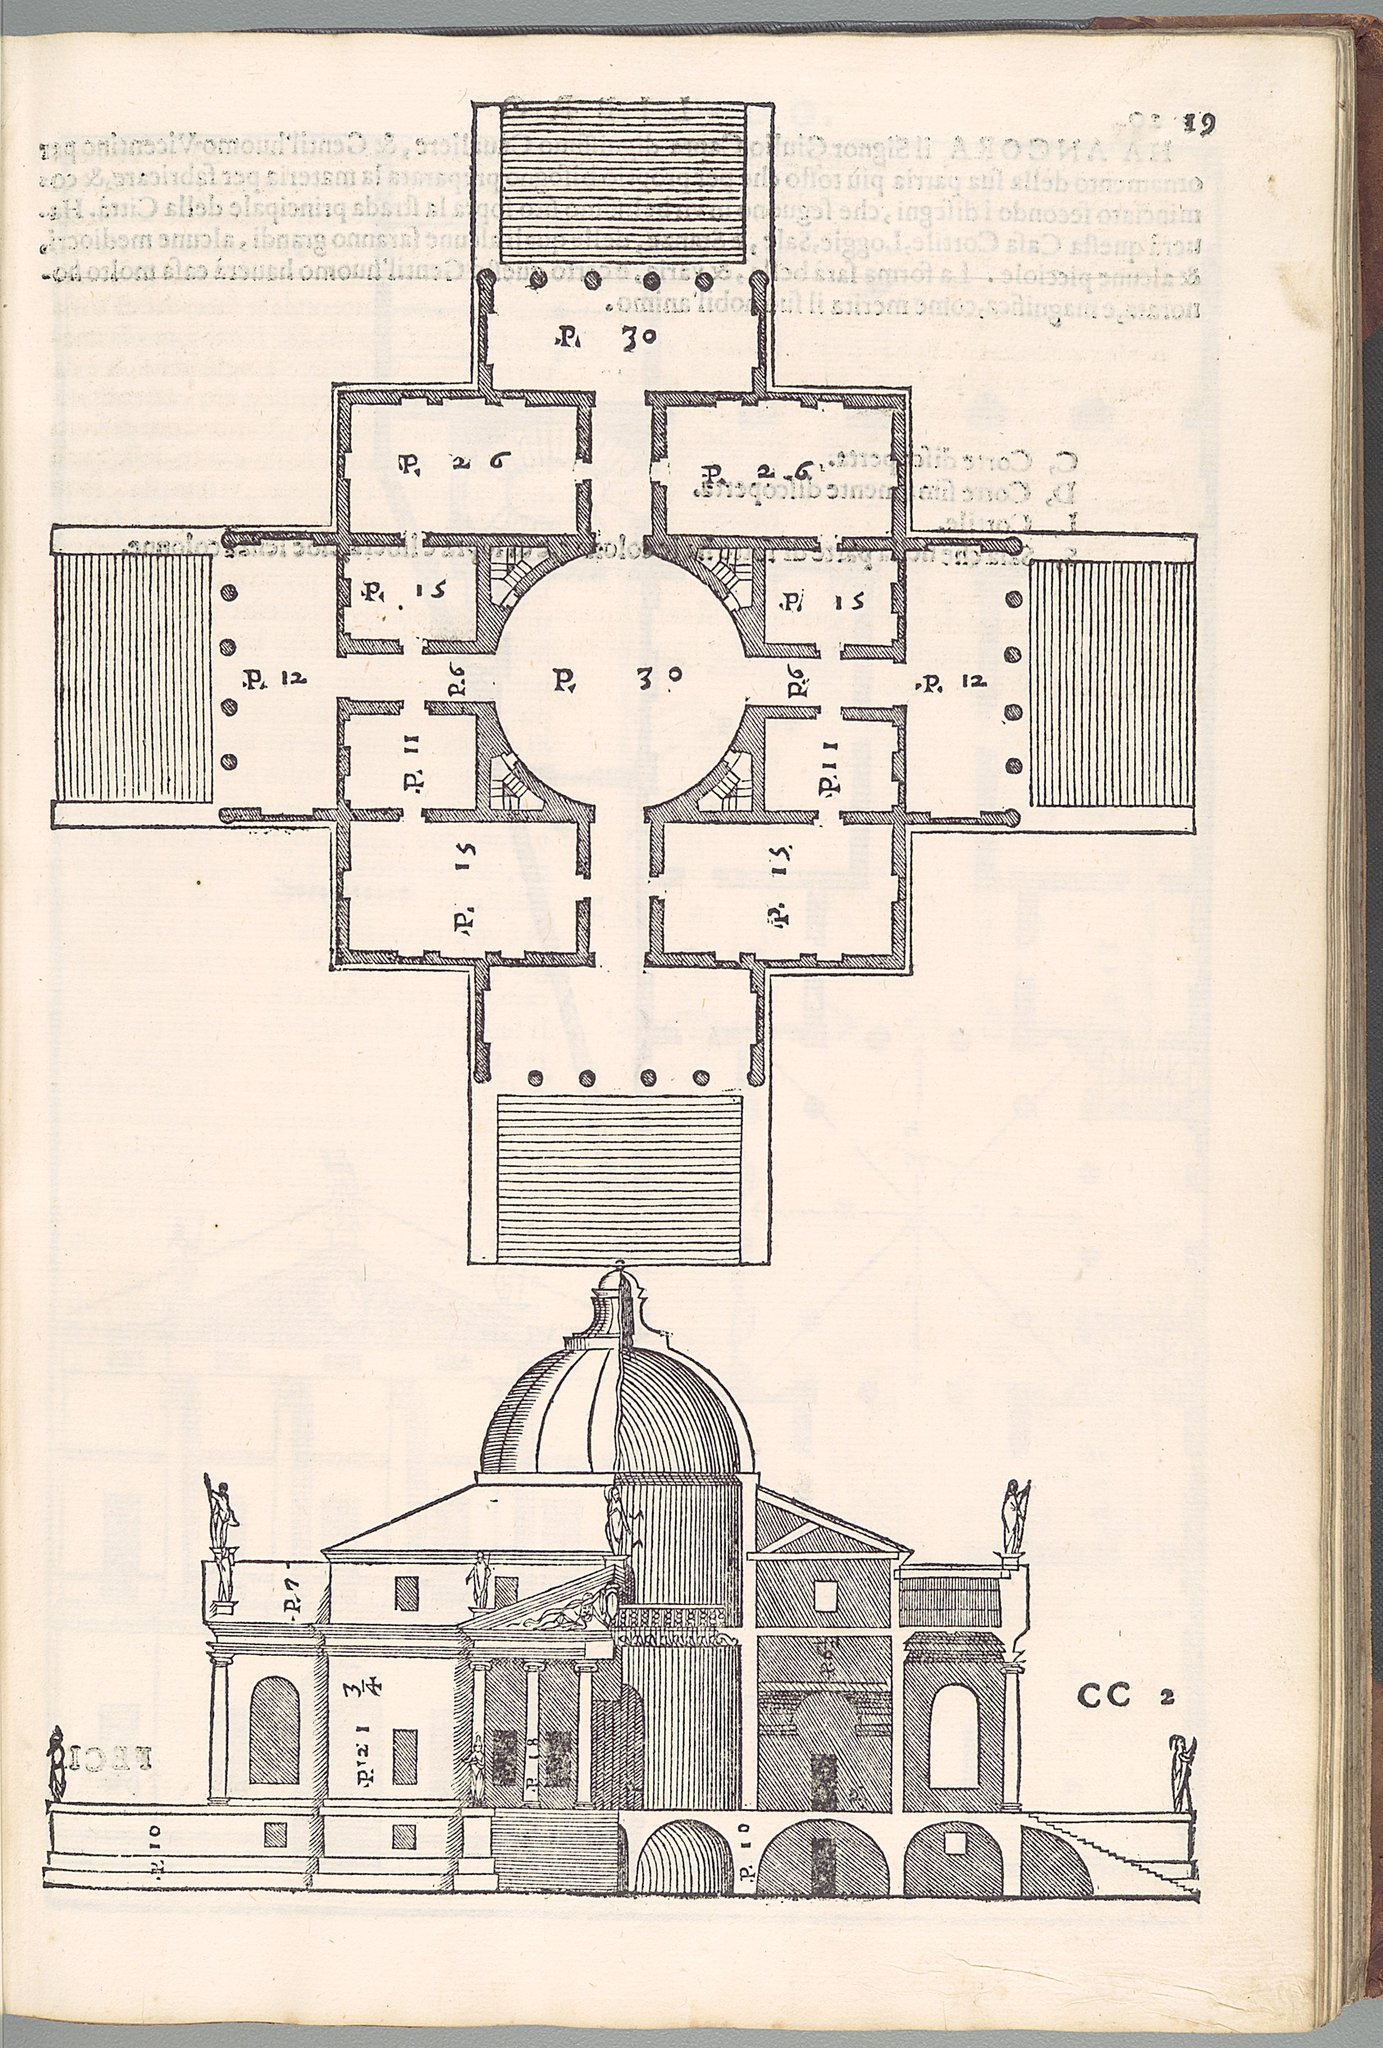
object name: book print ornament architecture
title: I quattro libri dell'architettura di Andrea Palladio. Ne'quale dopo un breue trattato de' cinque ordini (Book 2, page 19)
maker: andrea palladio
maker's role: author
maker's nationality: italian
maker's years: 1508-1580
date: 1581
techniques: printing, woodcut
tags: architecture